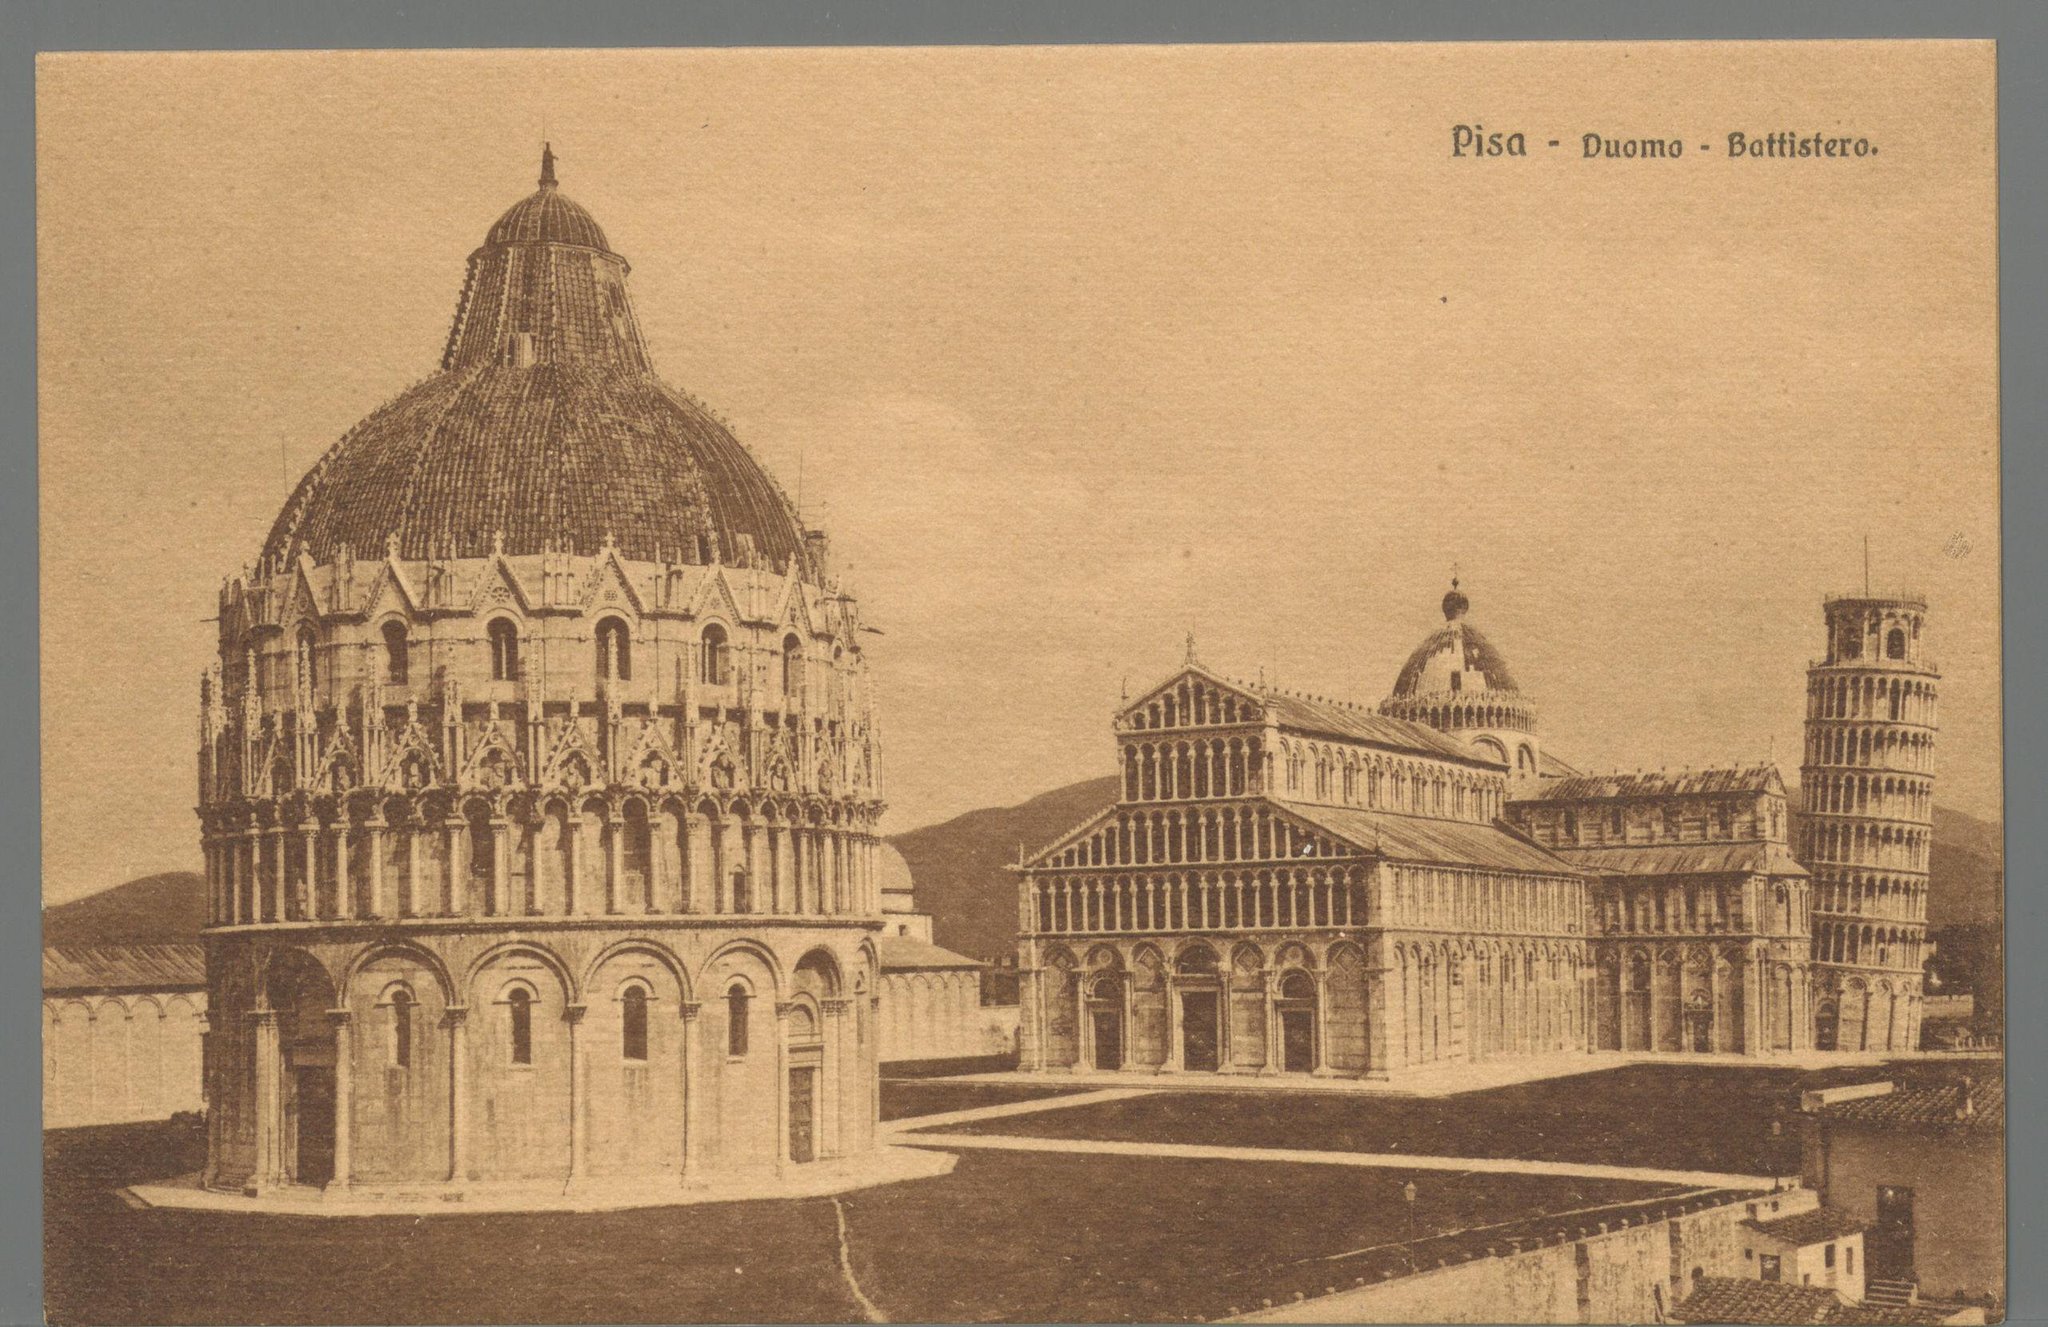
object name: photomechanical print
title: Pisa. Duomo. Battistero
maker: Anonymous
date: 1906-1909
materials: cardboard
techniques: photograph, writing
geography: pisa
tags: square, place, circus, etc., church (exterior)